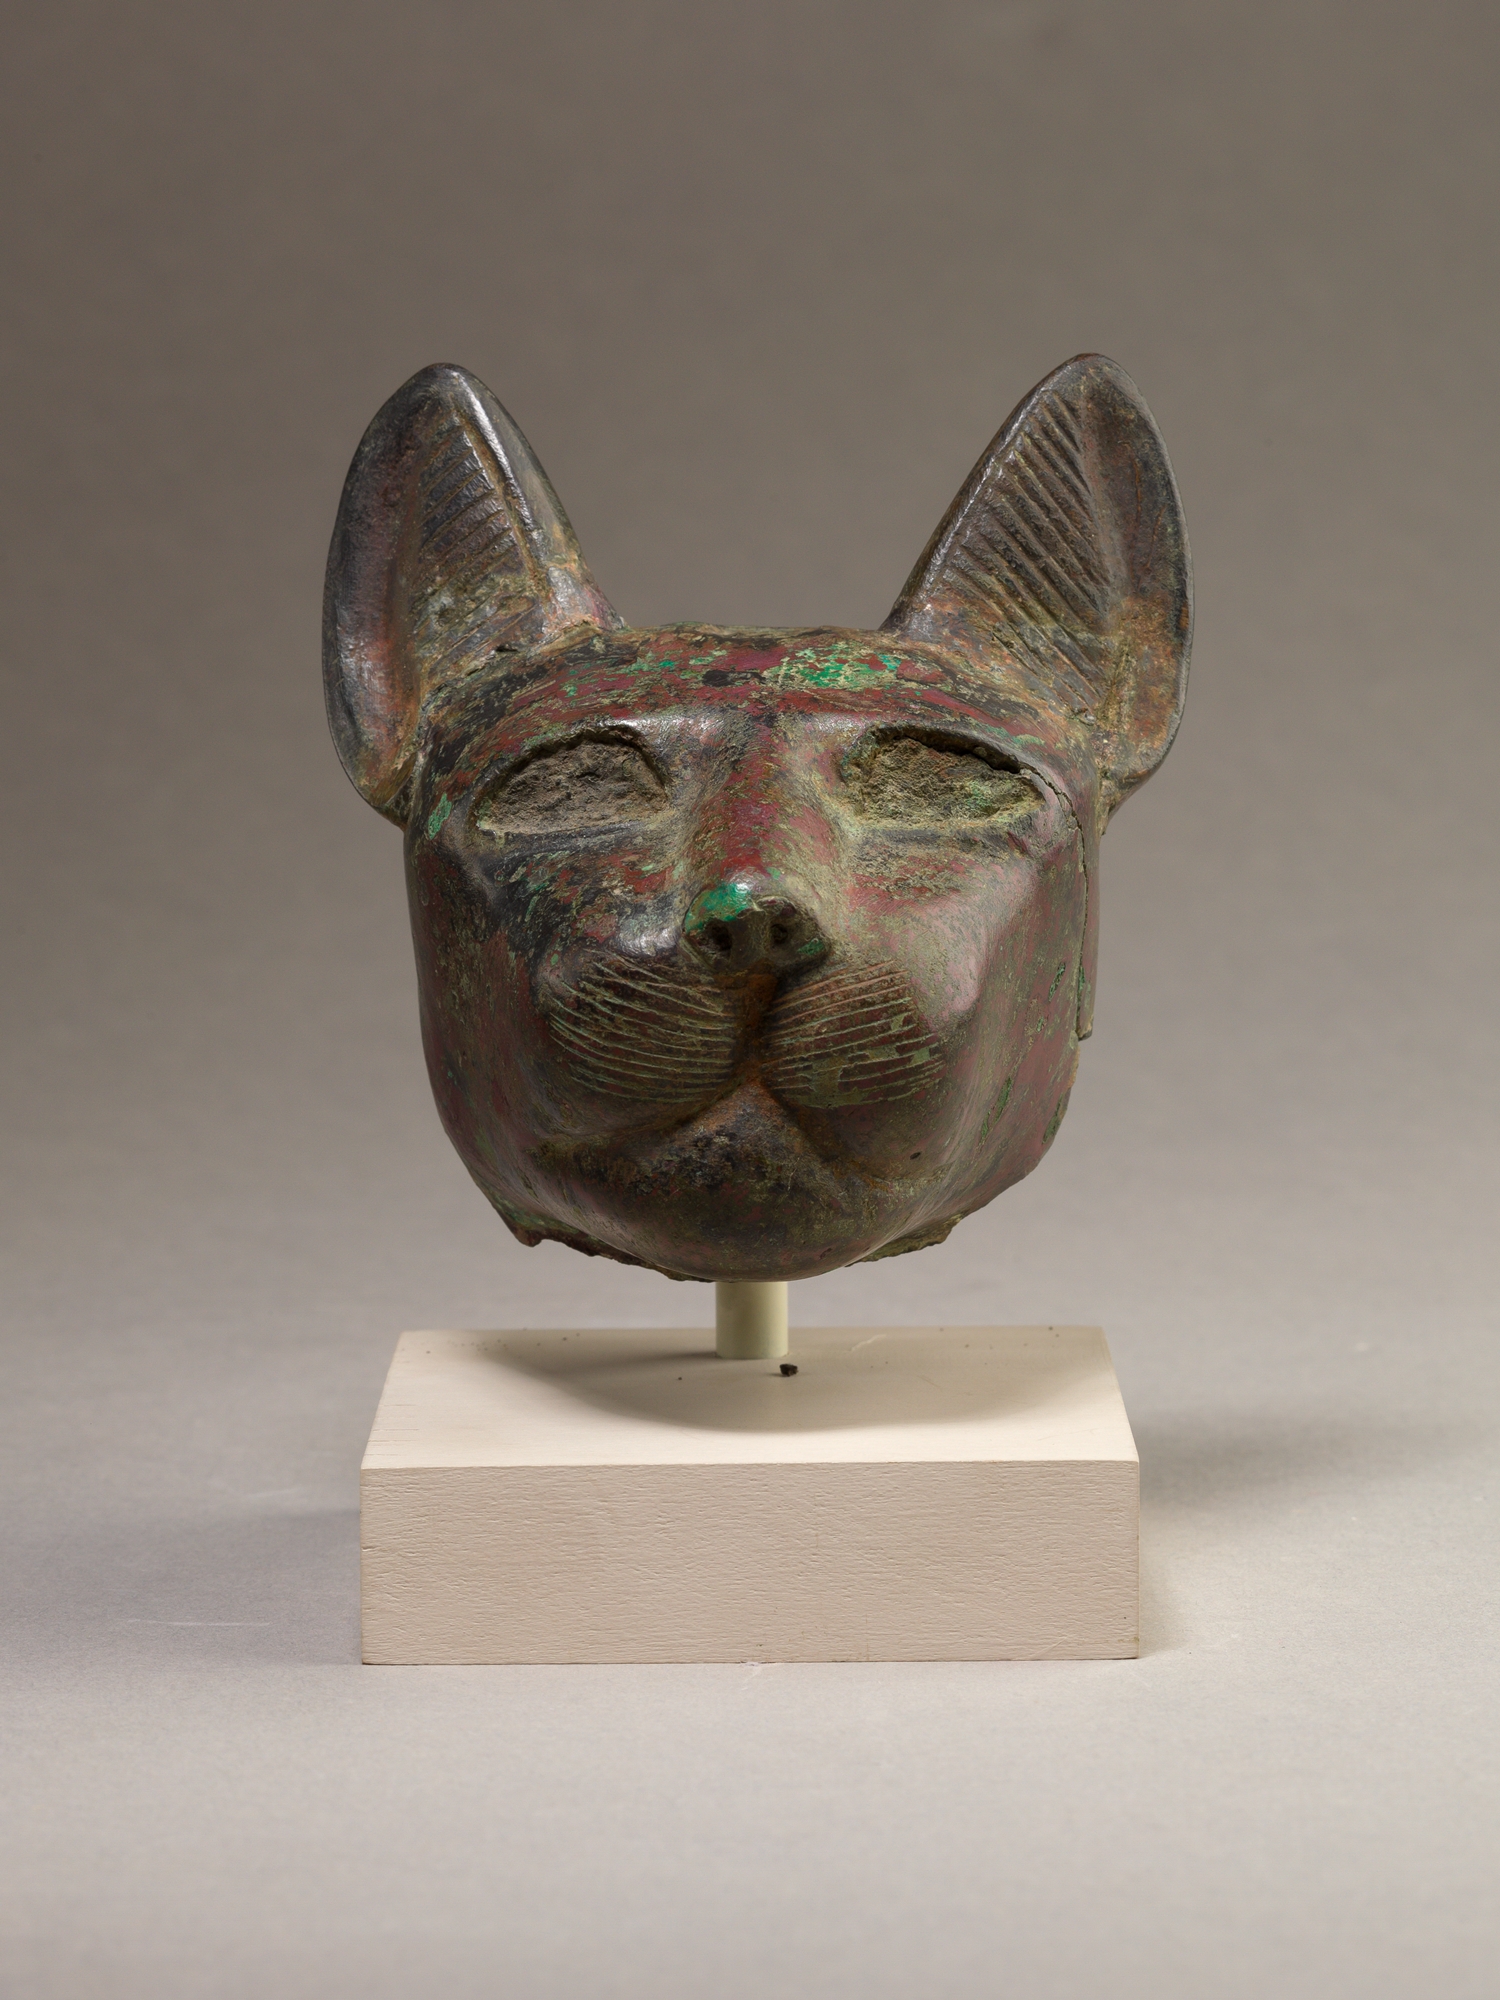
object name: head, cat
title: Head of a cat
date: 664-332 BCE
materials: metal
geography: egypt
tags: cats